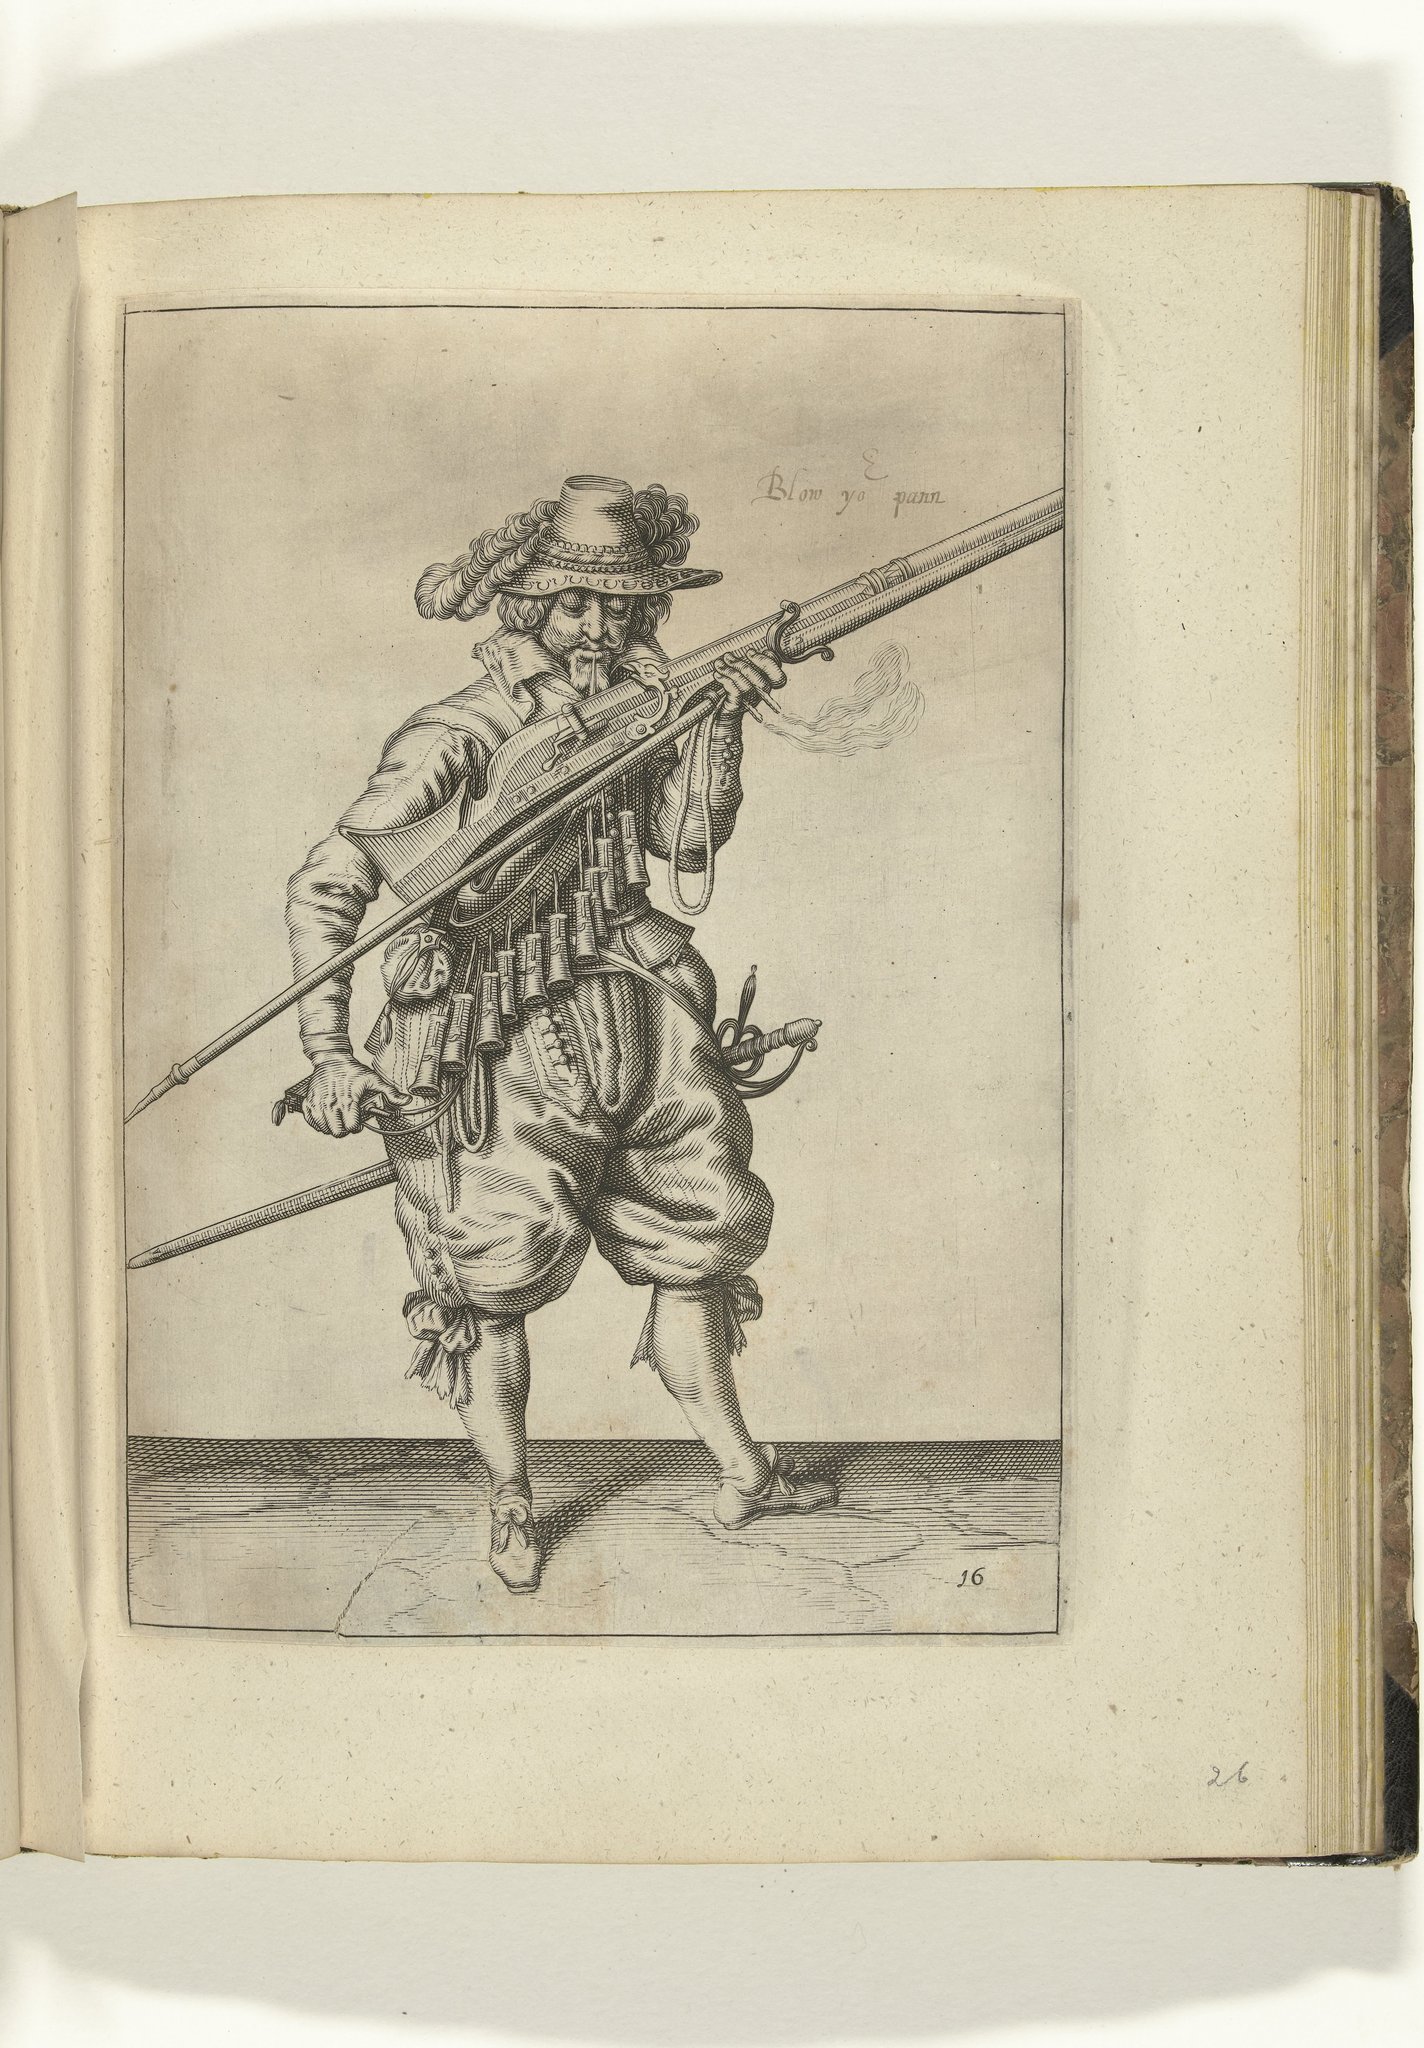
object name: print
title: Soldaat die vonken wegblaast van de pan van zijn musket (nr. 16), ca. 1600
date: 1597-1608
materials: paper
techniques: engraving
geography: northern netherlands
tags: the hague, maurice (prince of orange), handling of weapons ~ military training, weapons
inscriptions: inscription: ‘Blow ye pann’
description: Een soldaat, ten voeten uit, naar rechts, die een musket (een bepaald type vuurwapen) bij zijn mond houdt en over de pan (het kruitreservoir) blaast (nr. 16), ca. 1600. In zijn linkerhand behalve het musket ook een furket (musketvork) en een brandende lont. In zijn rechterhand een kruitfles. Plaat 16 in de instructies voor het hanteren van het musket: Shorte instruction for the figures, so much concerneth the right use of muskett. Onderdeel van de illustraties in een Engelse editie van J. de Gheyns Wapenhandelinghe: J. de Gheyn, The exercise of armes for calivres, muskettes and pikes after the ordre of Maurits Prince of Orange, 's-Gravenhage 1608. Krijgswezen rond 1600.